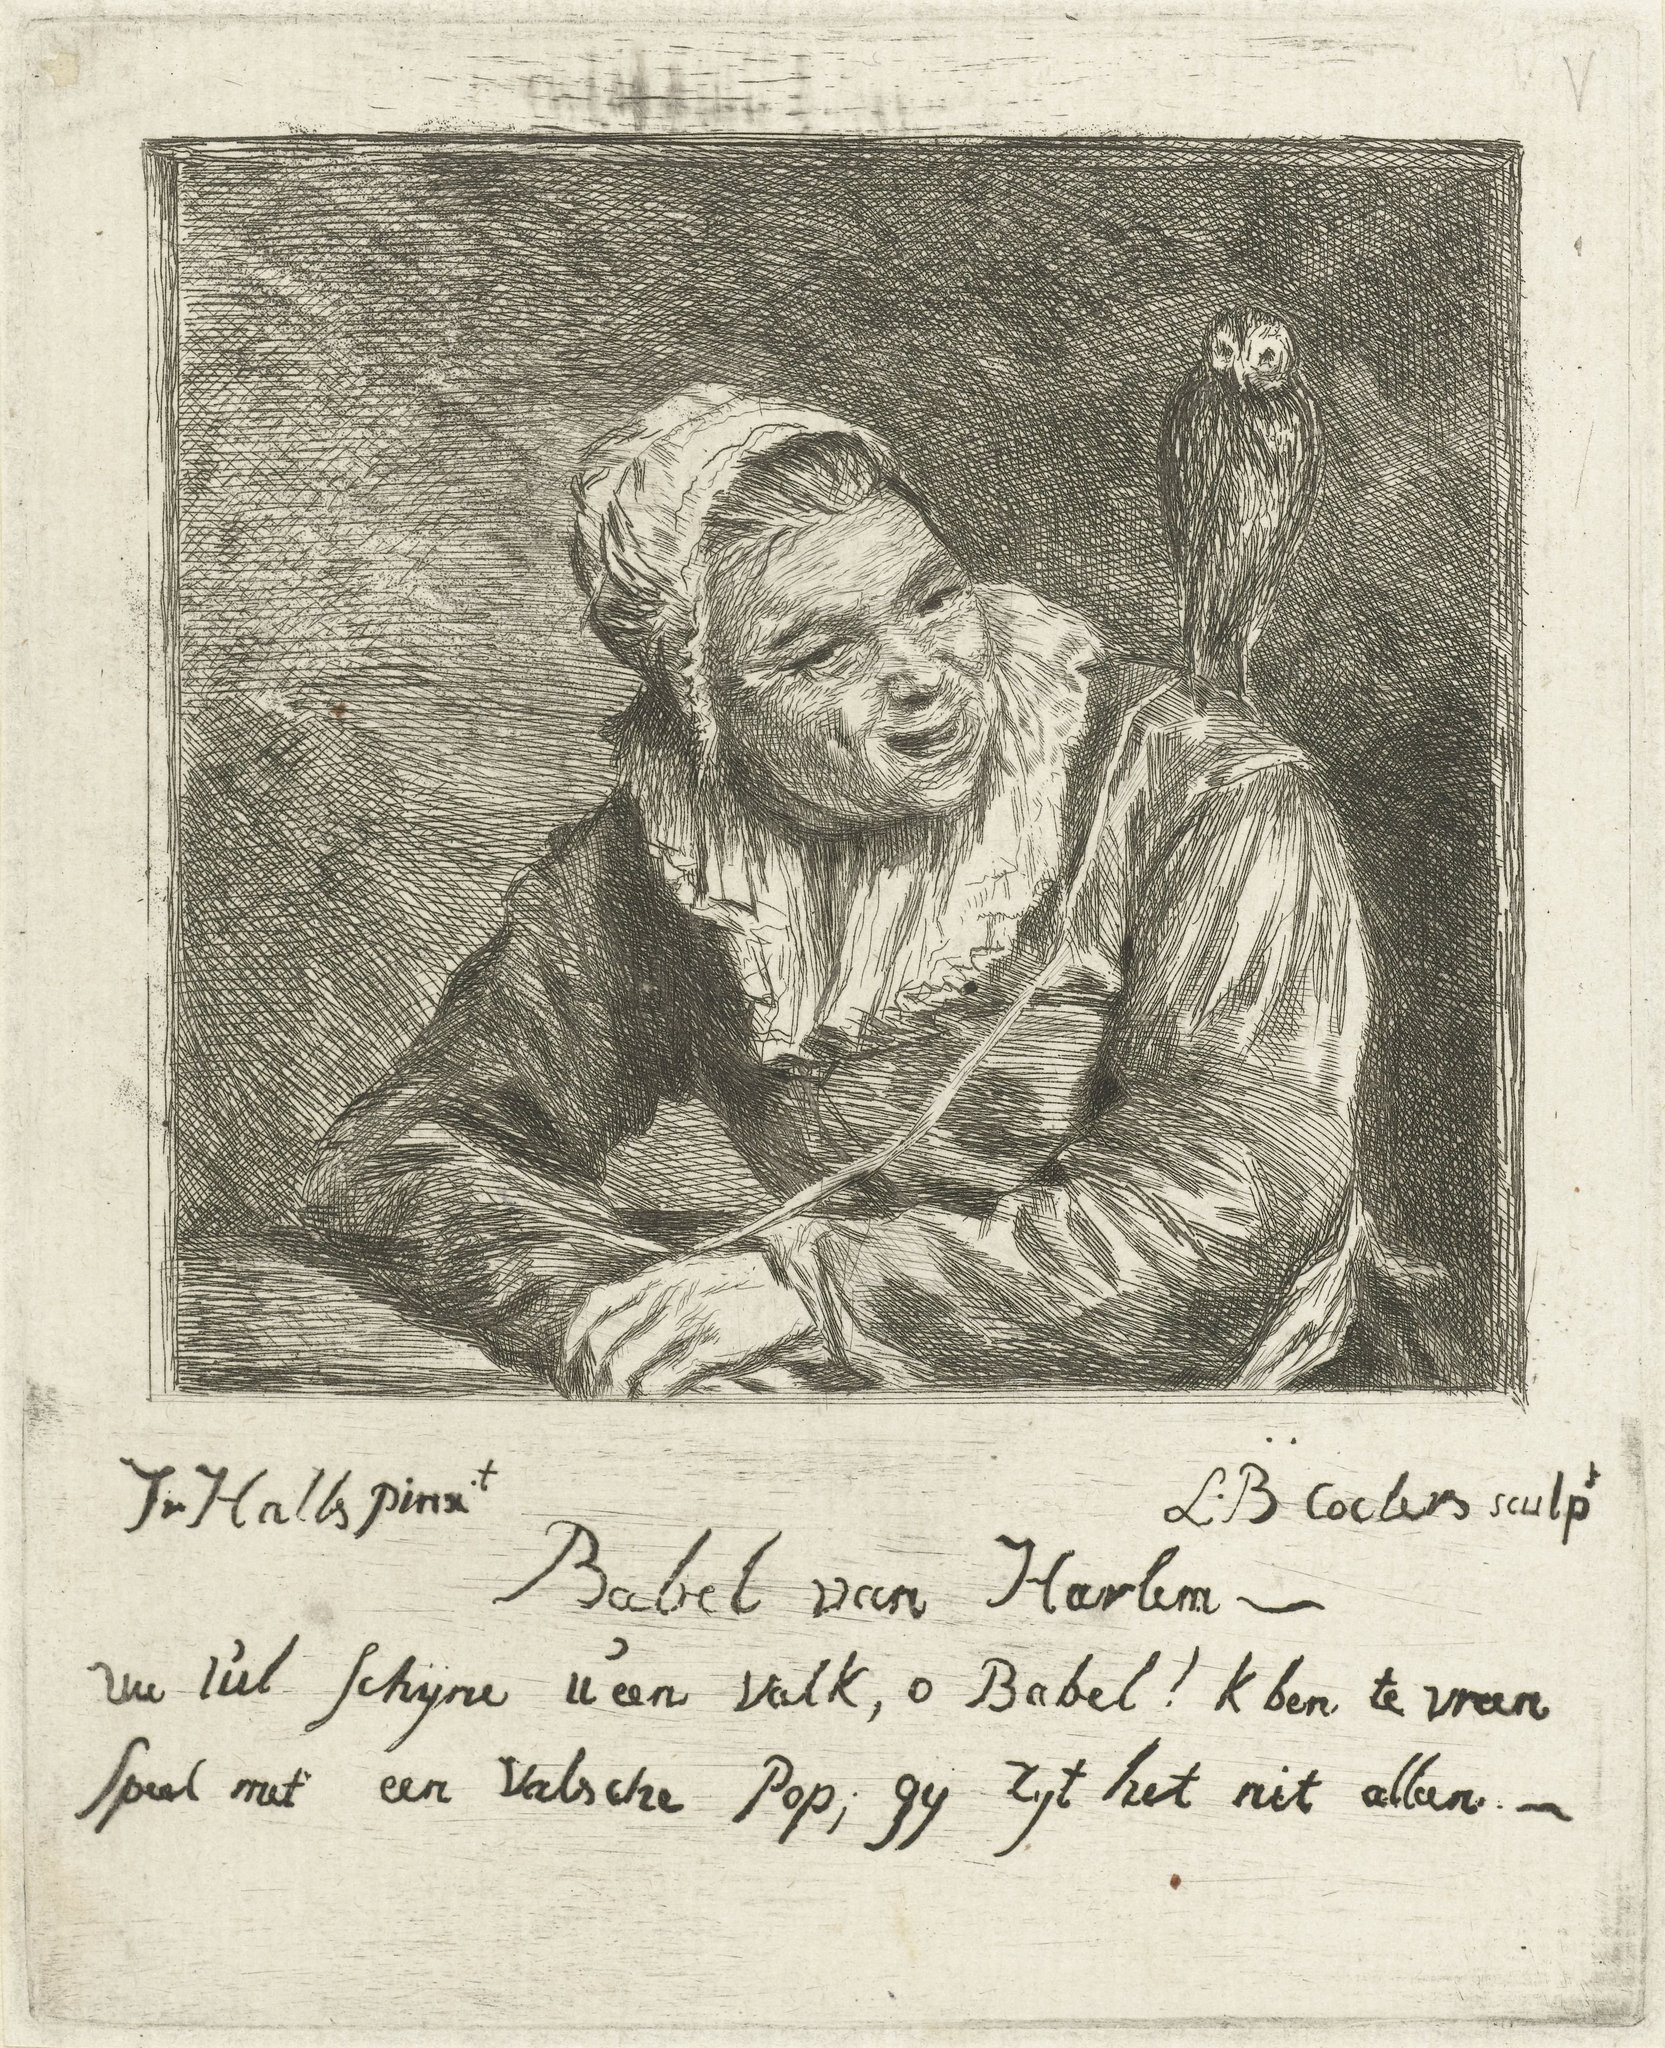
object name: print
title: Malle Babbe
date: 1756-1817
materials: paper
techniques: drypoint, etching, roulette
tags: witch, sorceress, owls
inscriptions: collector's mark: Lugt 2228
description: Portretbuste van een lachende oude vrouw met wit kapje en kraag. Op haar schouder zit een uil. Onder de voorstelling een Nederlands vers over de vrouw en de vogel.